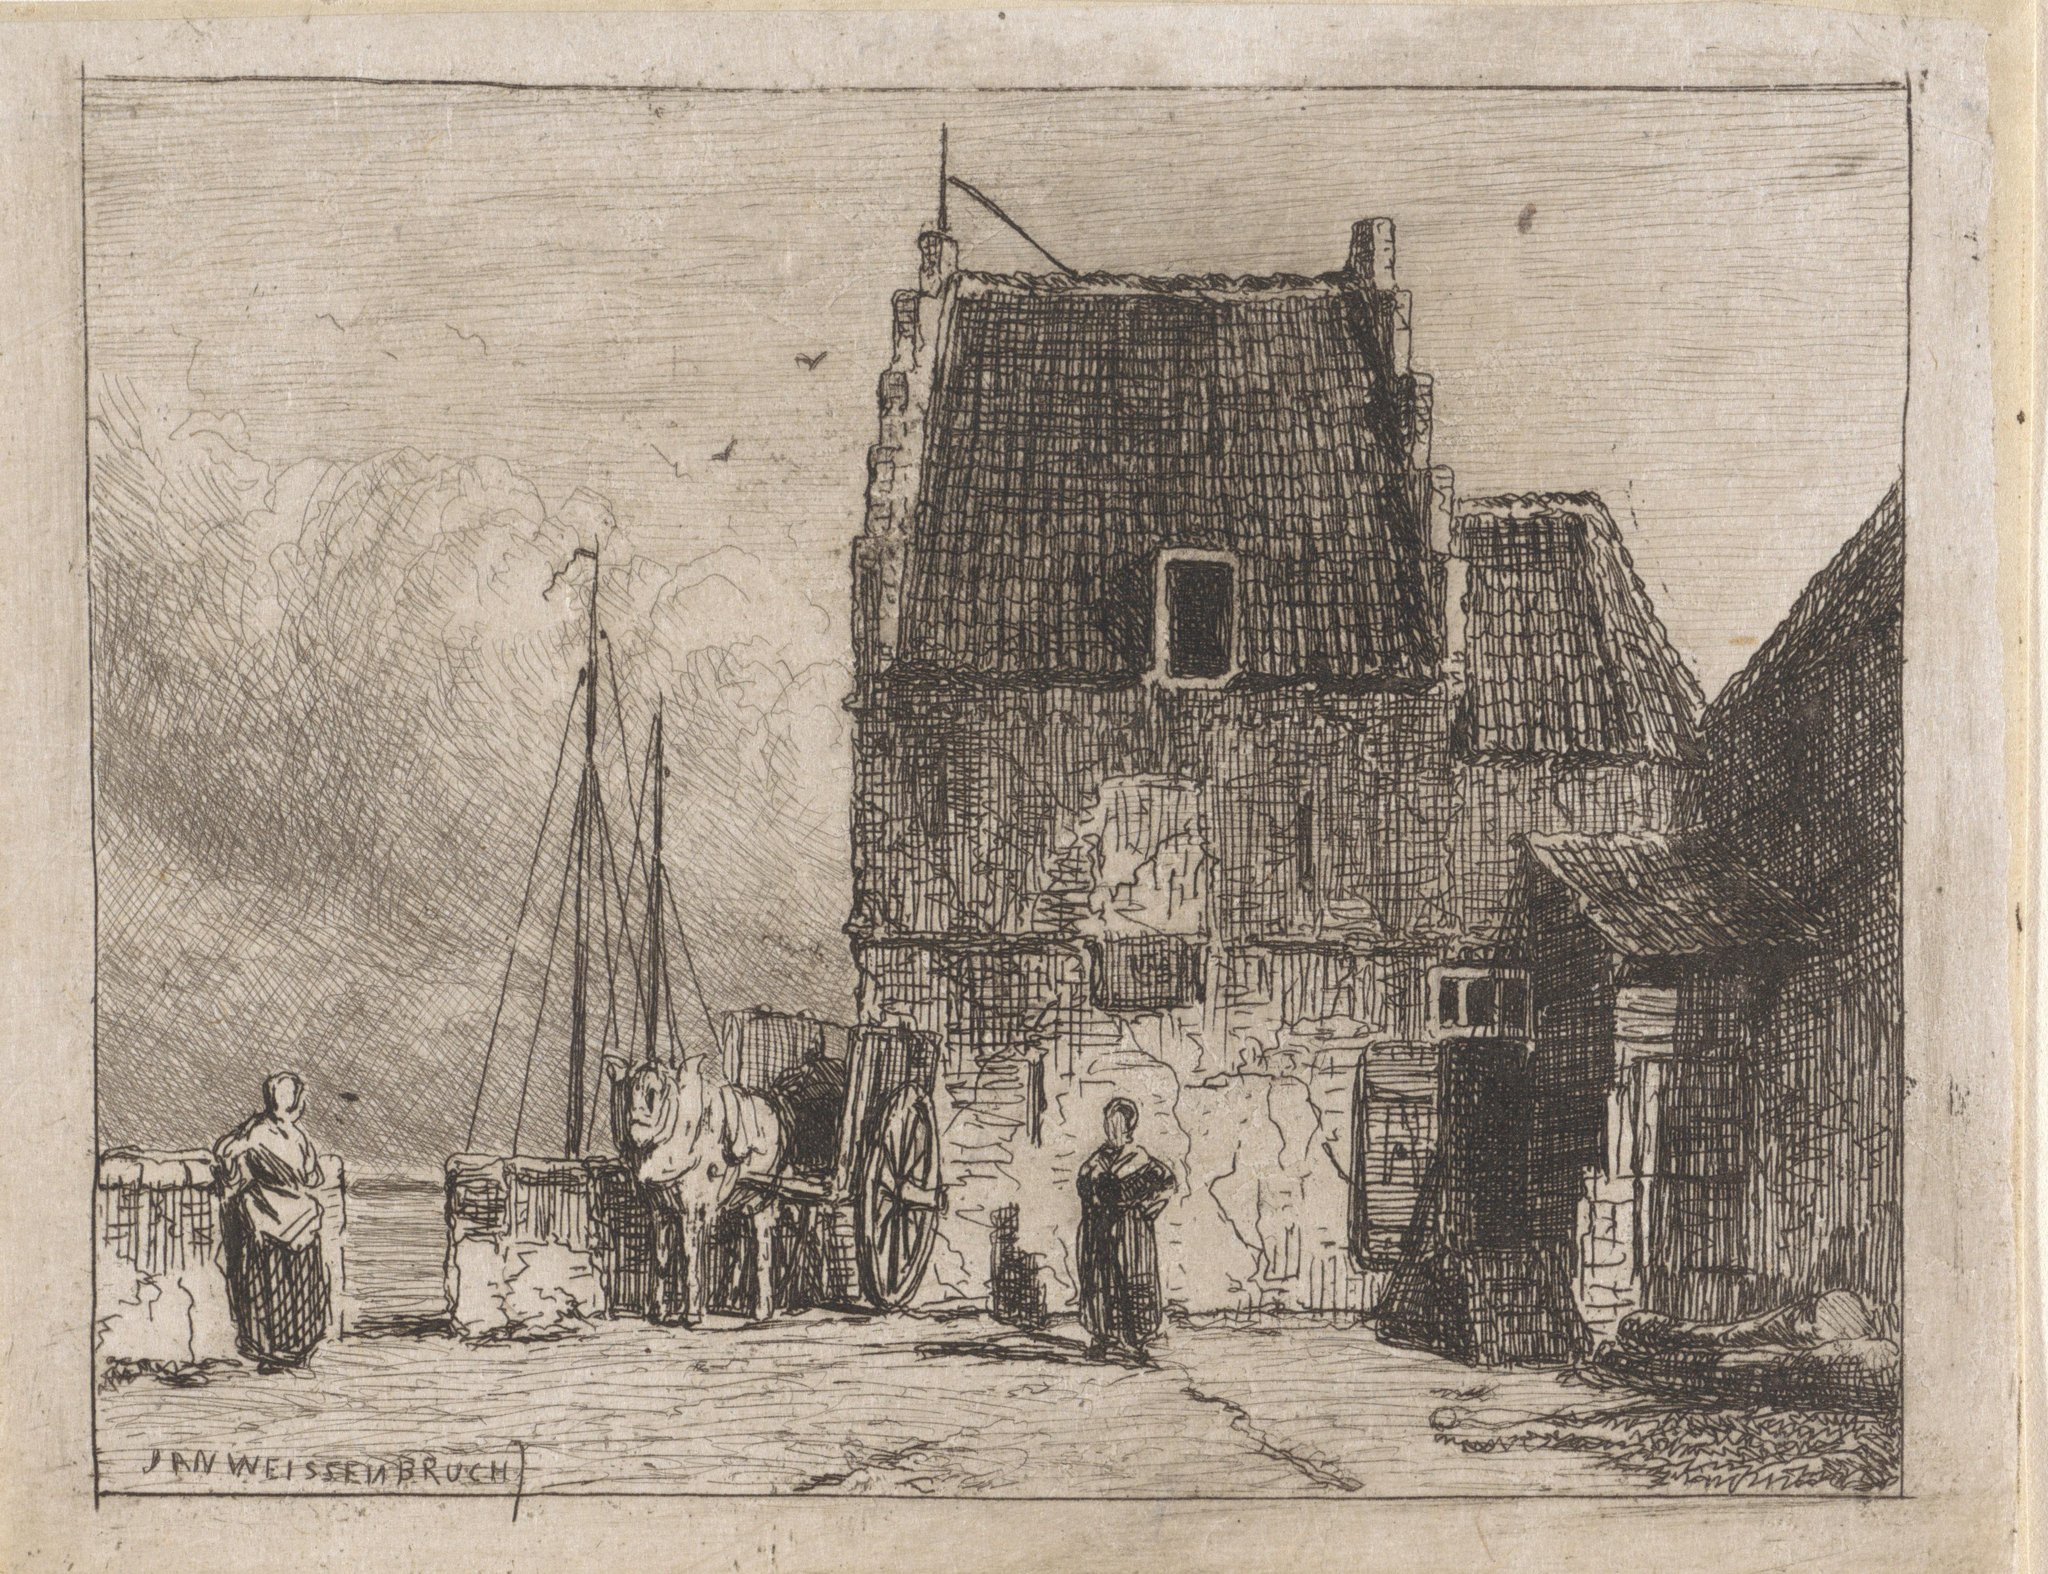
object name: print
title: Huis aan het water te Nijmegen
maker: jan weissenbruch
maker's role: painter, print maker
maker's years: 1822-1880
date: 1837-1880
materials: paper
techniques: etching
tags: adult woman, sailing-ship, sailing-boat, river, horse, civic architecture; edifices; dwellings, (farm) wagon, freight wagon, cart, nijmegen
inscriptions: collector's mark: Lugt 2228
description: Langs het water staat een huis. Voor het huis staat een kar met een paard. Ook zijn twee figuren weergegeven. Links ligt een zeilschip.